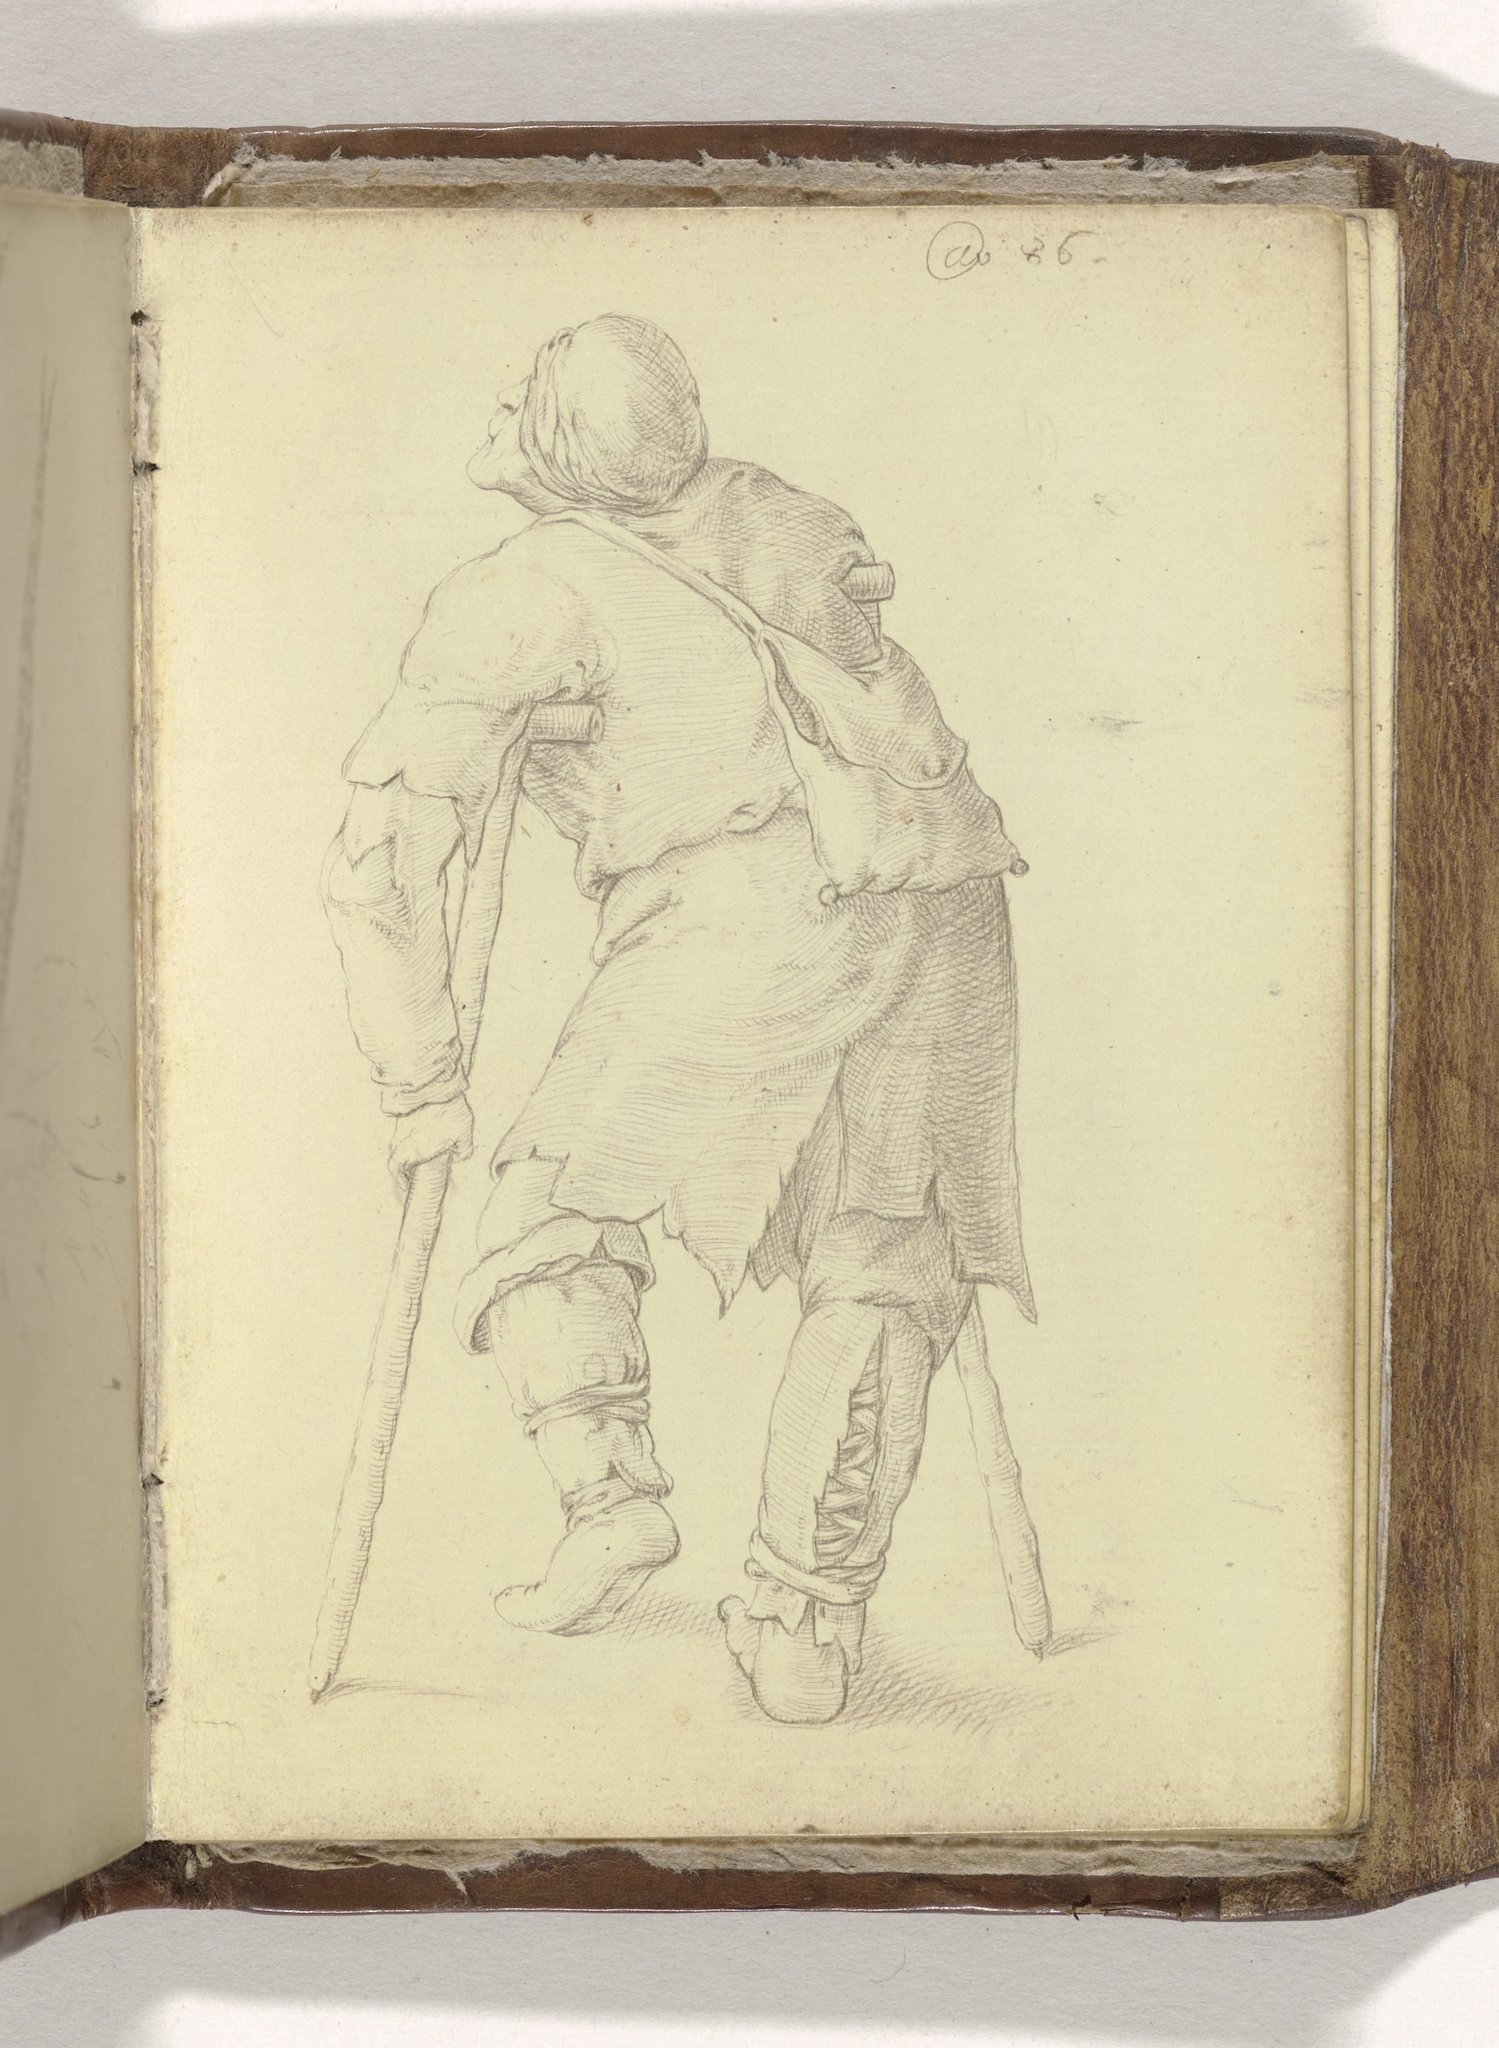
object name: kopie naar prent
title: Schetsboek "A.S.Fe", 1587, blad 6r(12)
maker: Anonymous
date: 1586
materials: paper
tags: beggar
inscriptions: date